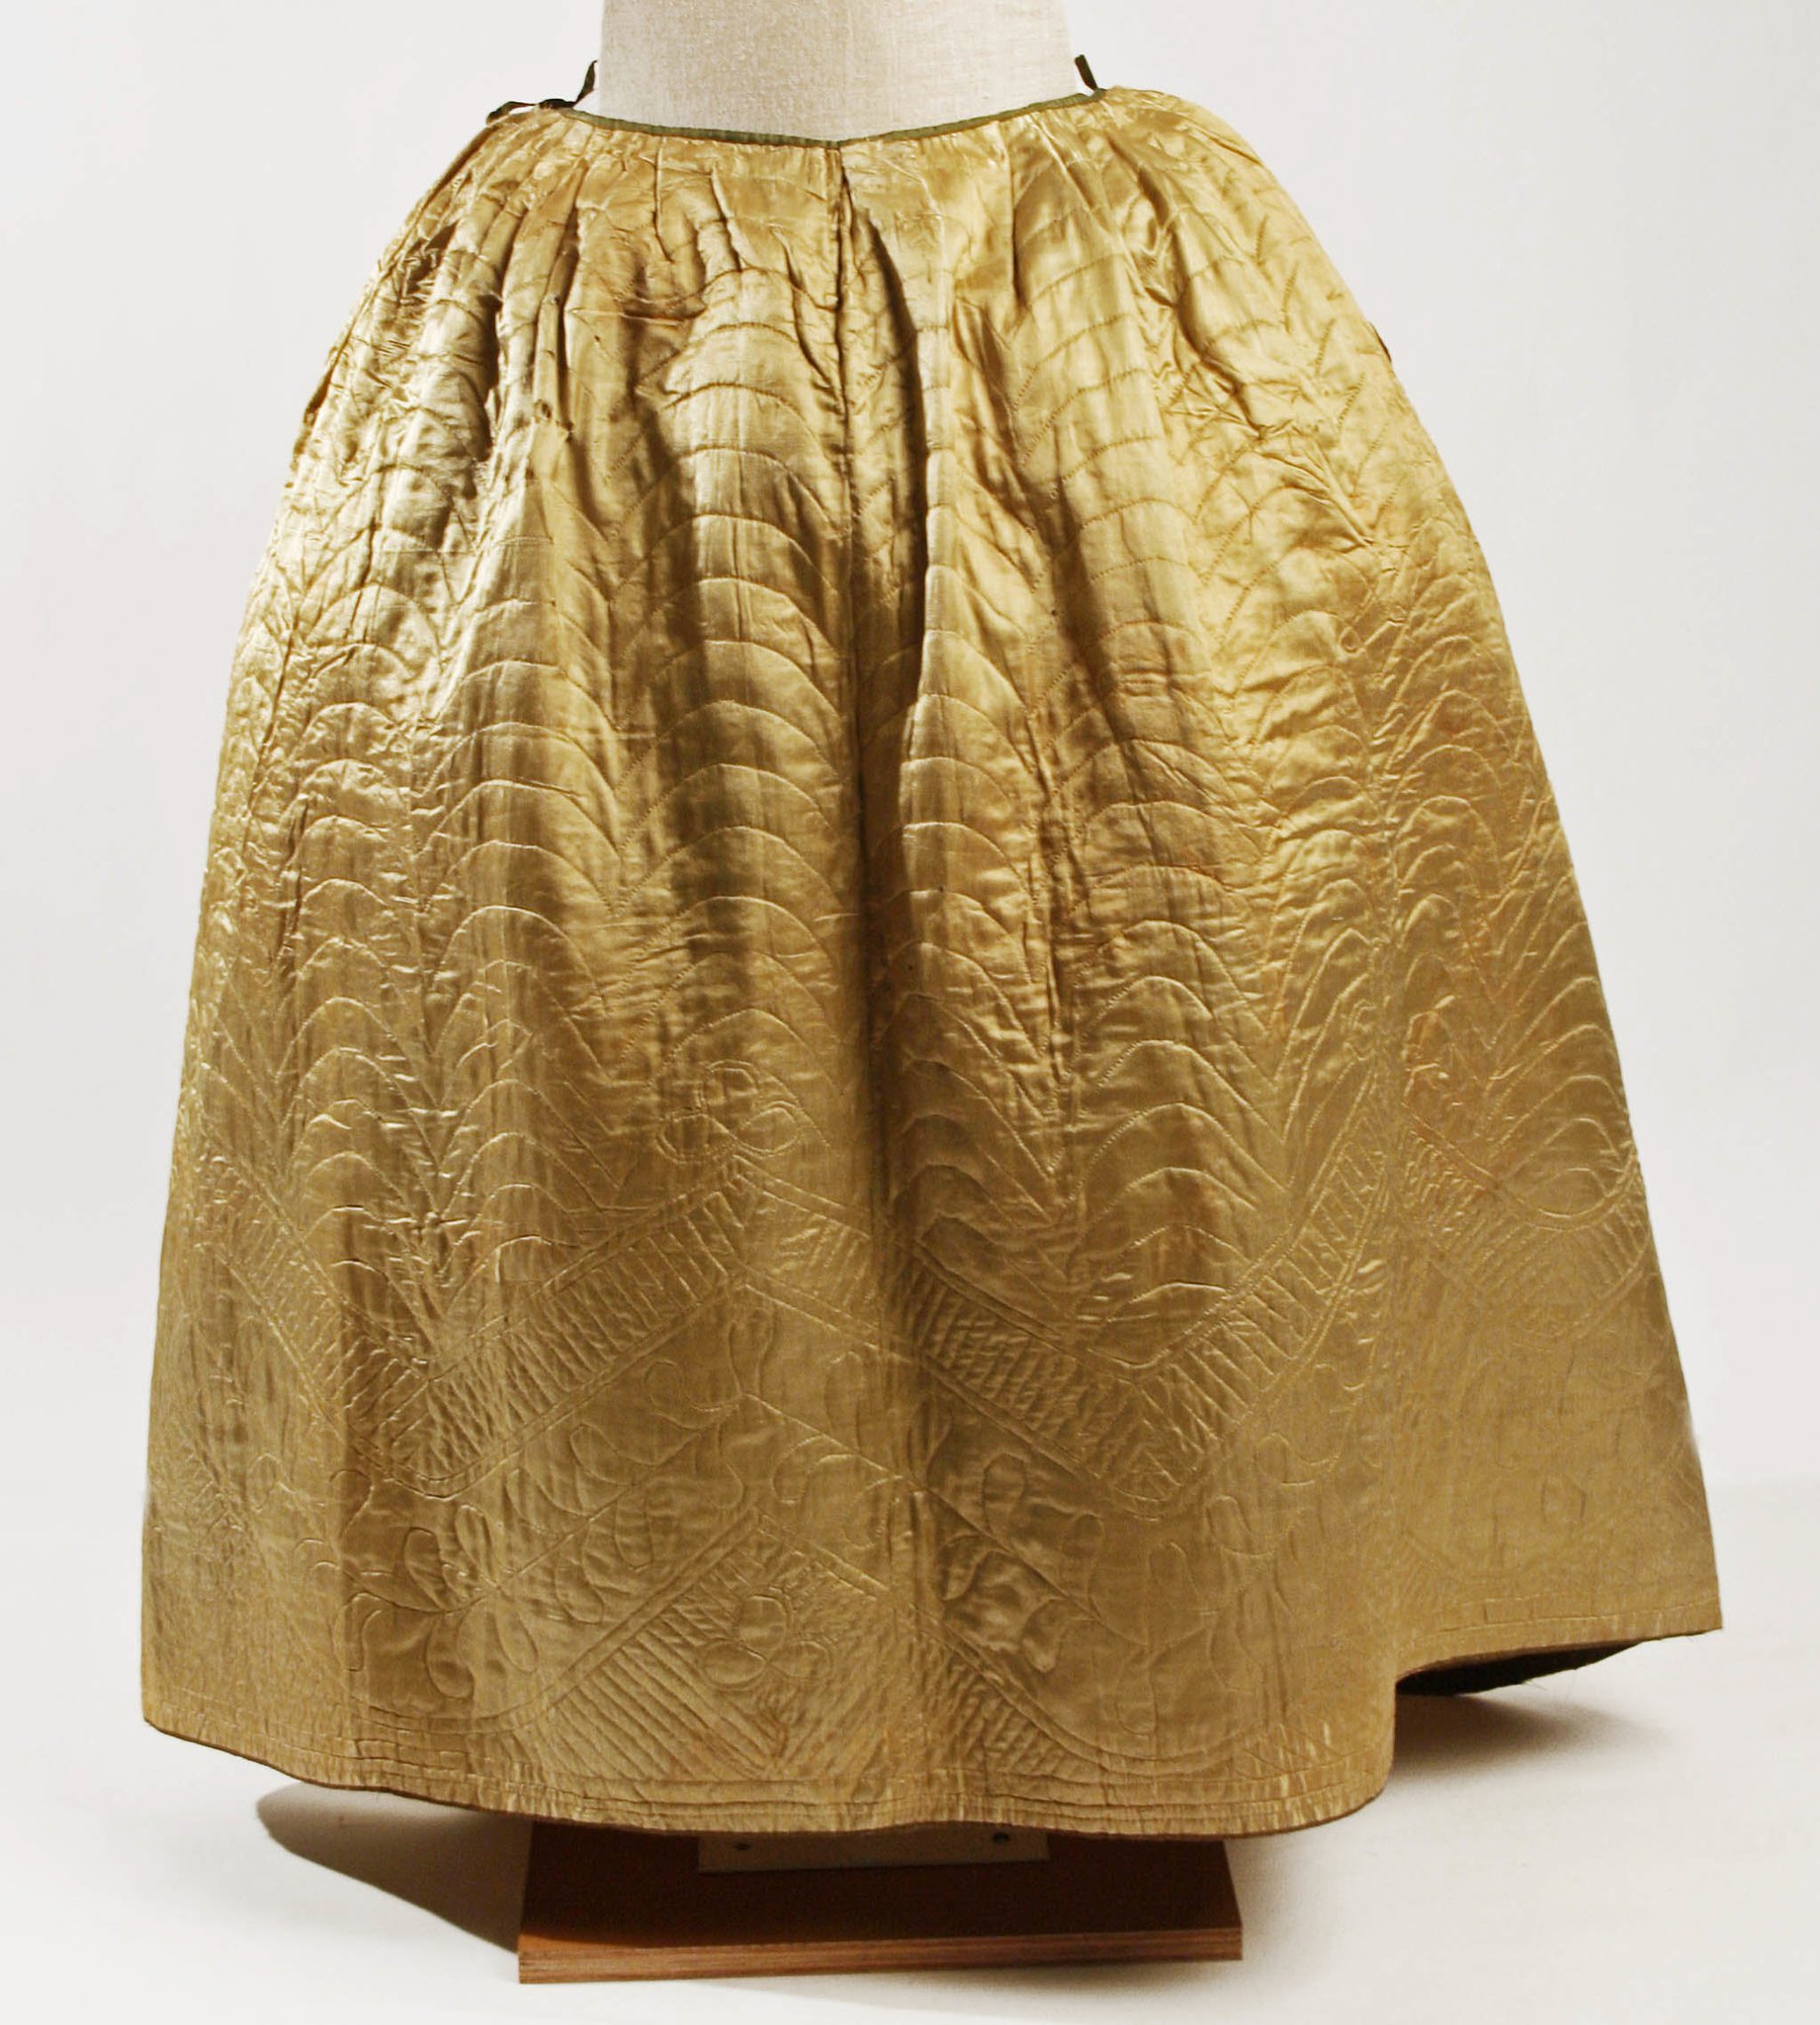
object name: petticoat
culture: american or european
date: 1701-1800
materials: silk